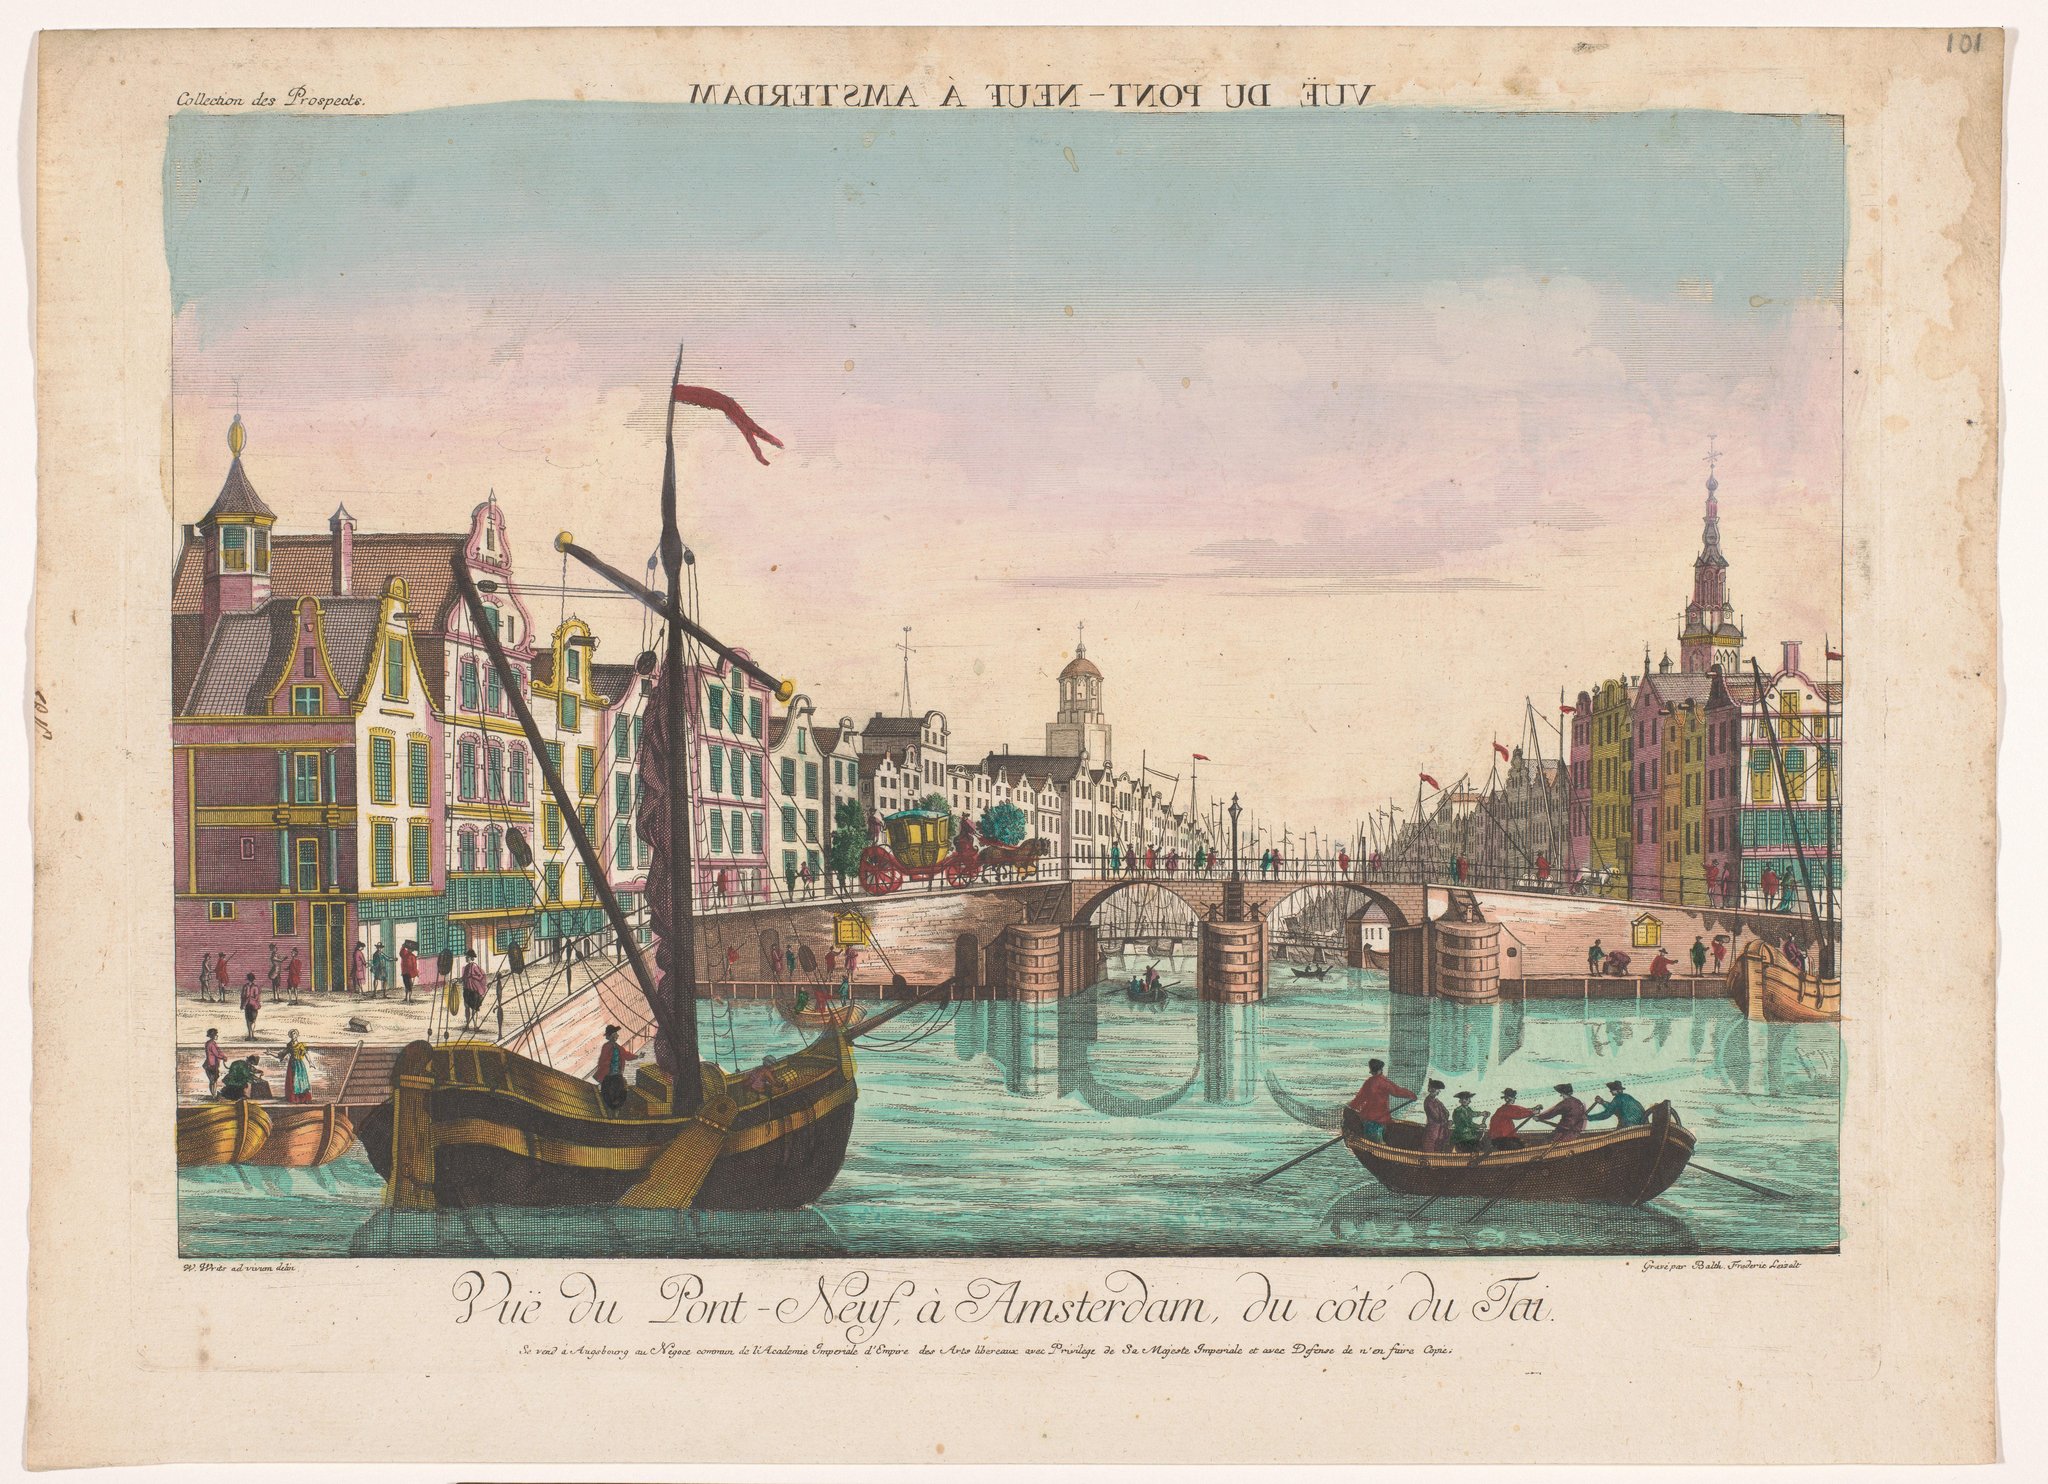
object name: opticaprent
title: Vuë du Pont-Neuf á Amsterdam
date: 1755-1779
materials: paper, watercolor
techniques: brush, etching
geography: augsburg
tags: bridge in city across river, canal, etc. (+ city(-scape) with figures, staffage), sailing-ship, sailing-boat, church (exterior), rowing-boat, canoe, etc., townhall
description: Op de achtergrond links het Stadhuis op de Dam en rechts de Oude Kerk.